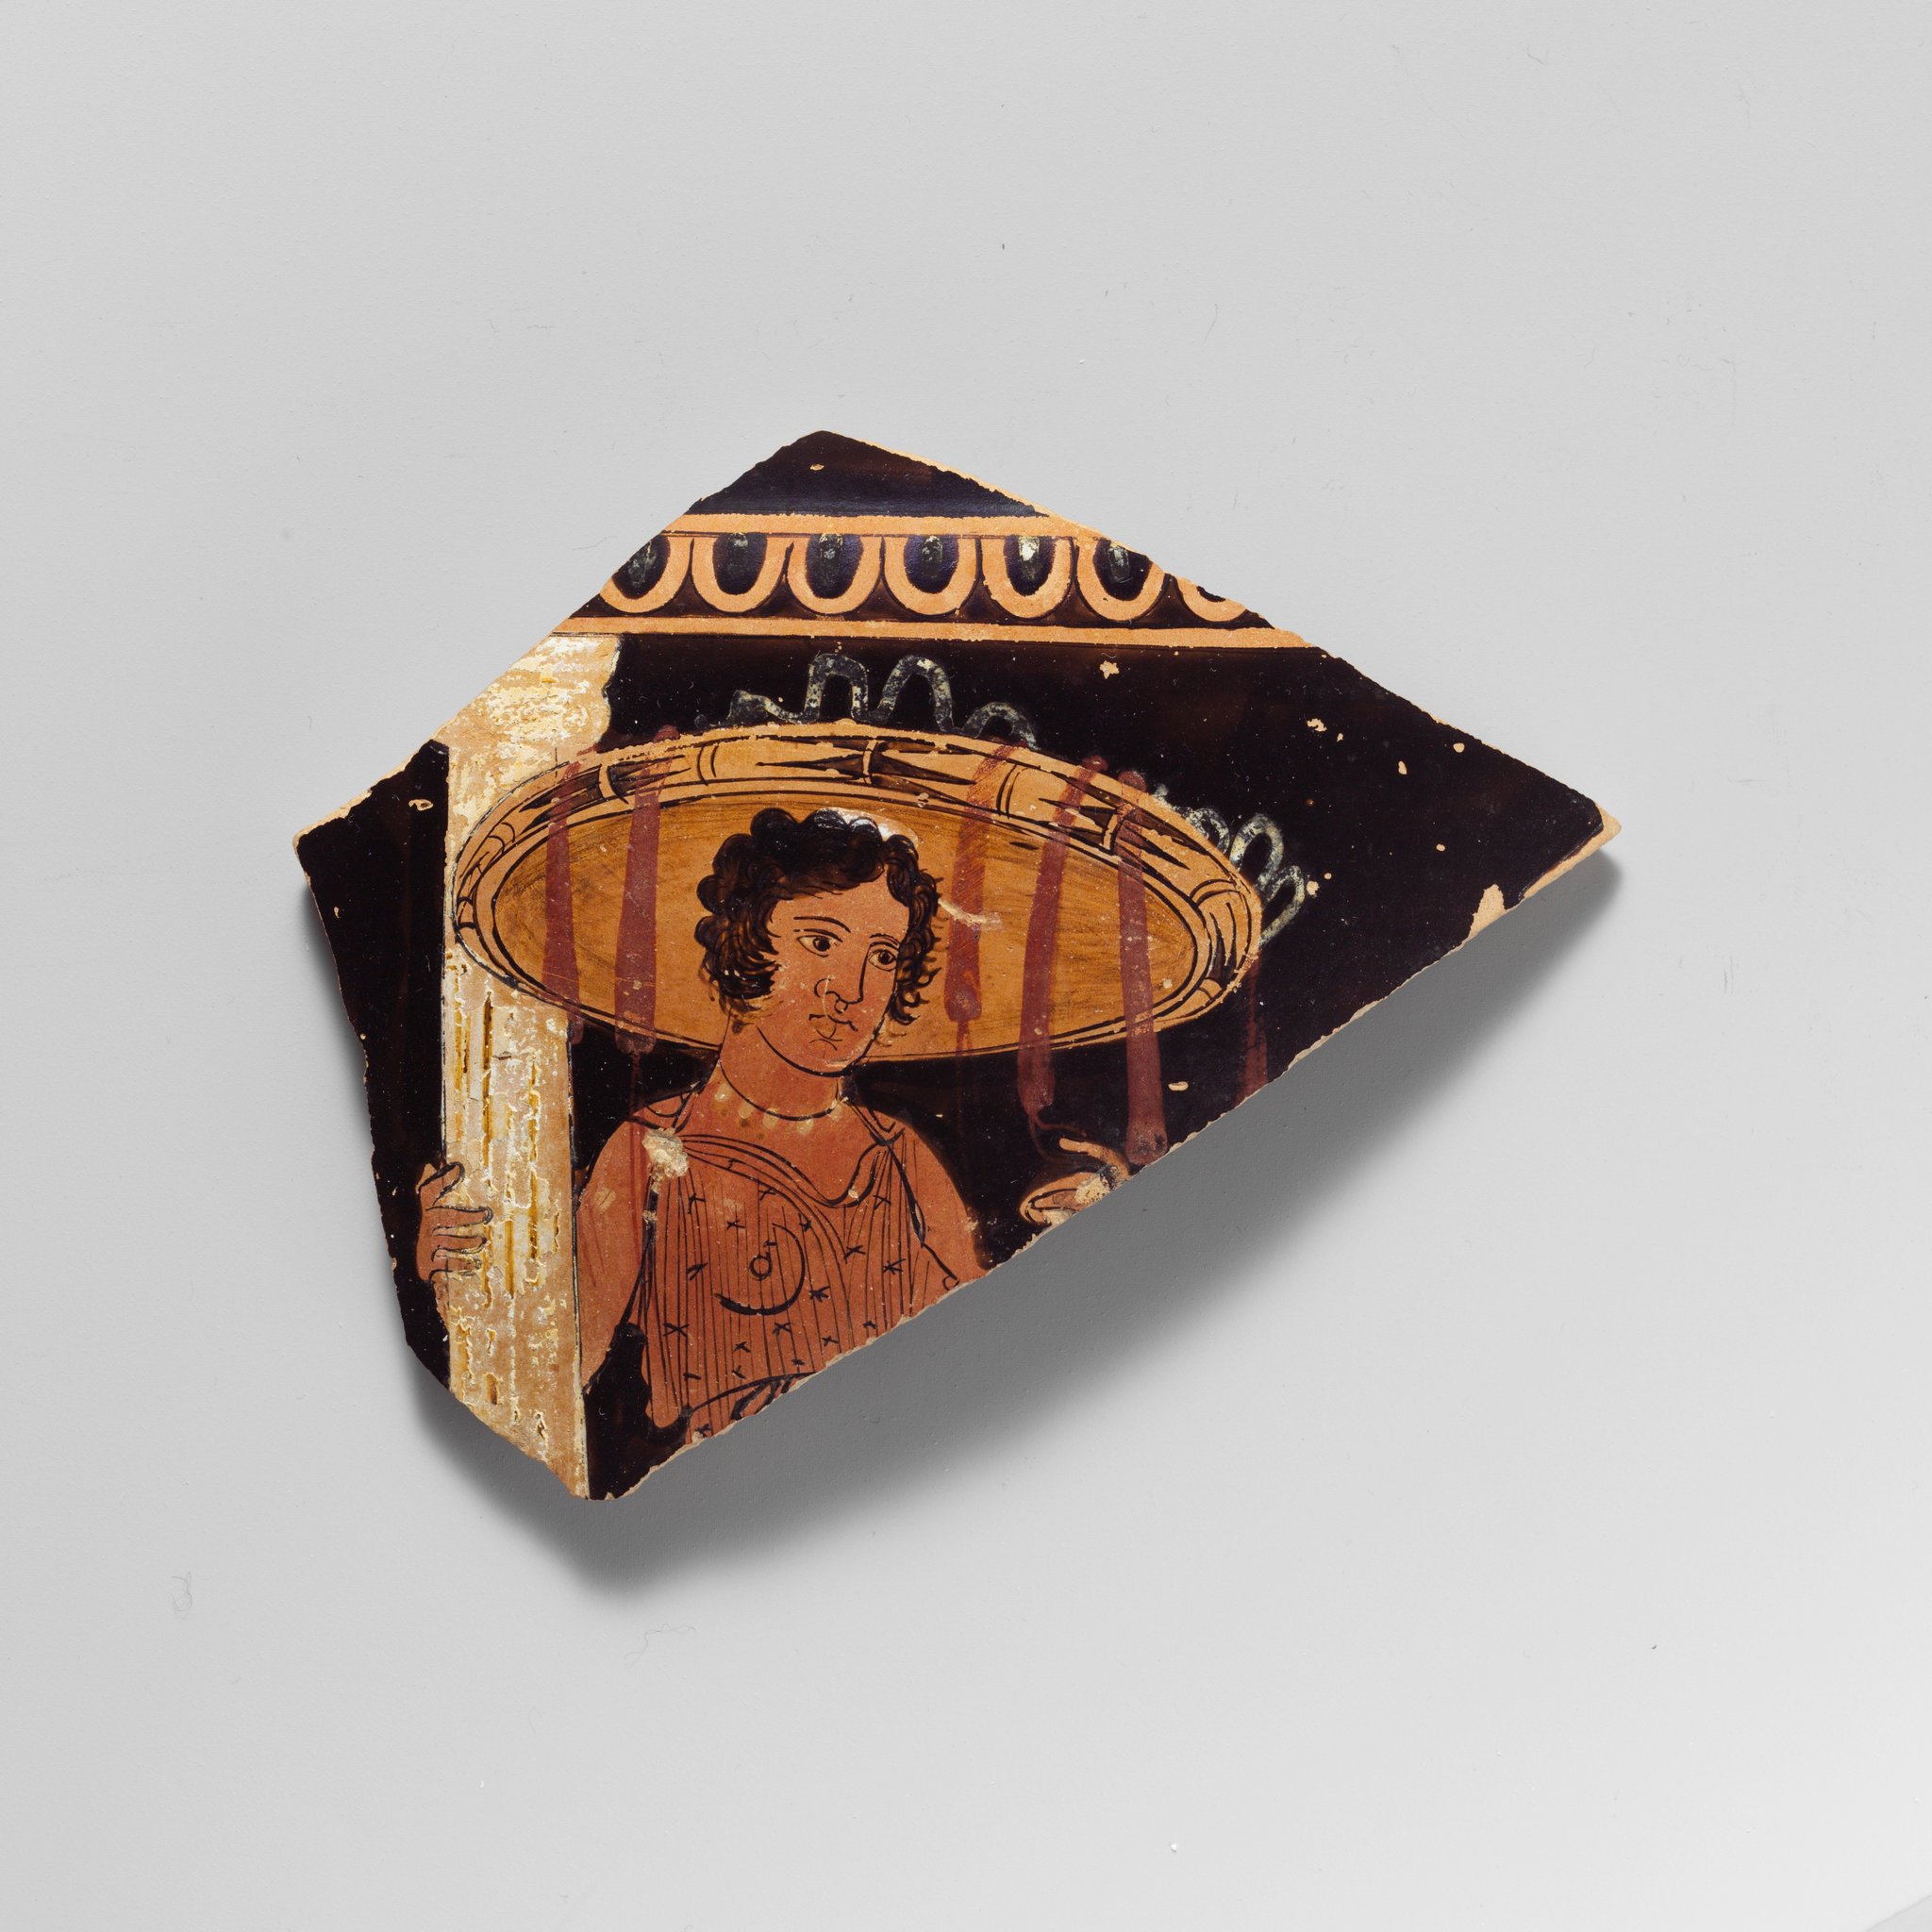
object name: neck amphora fragment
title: Fragment of a terracotta neck-amphora (jar)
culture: greek, paestan or south italian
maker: painter of the geneva orestes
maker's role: artist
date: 360-350 BCE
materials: terracotta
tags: women